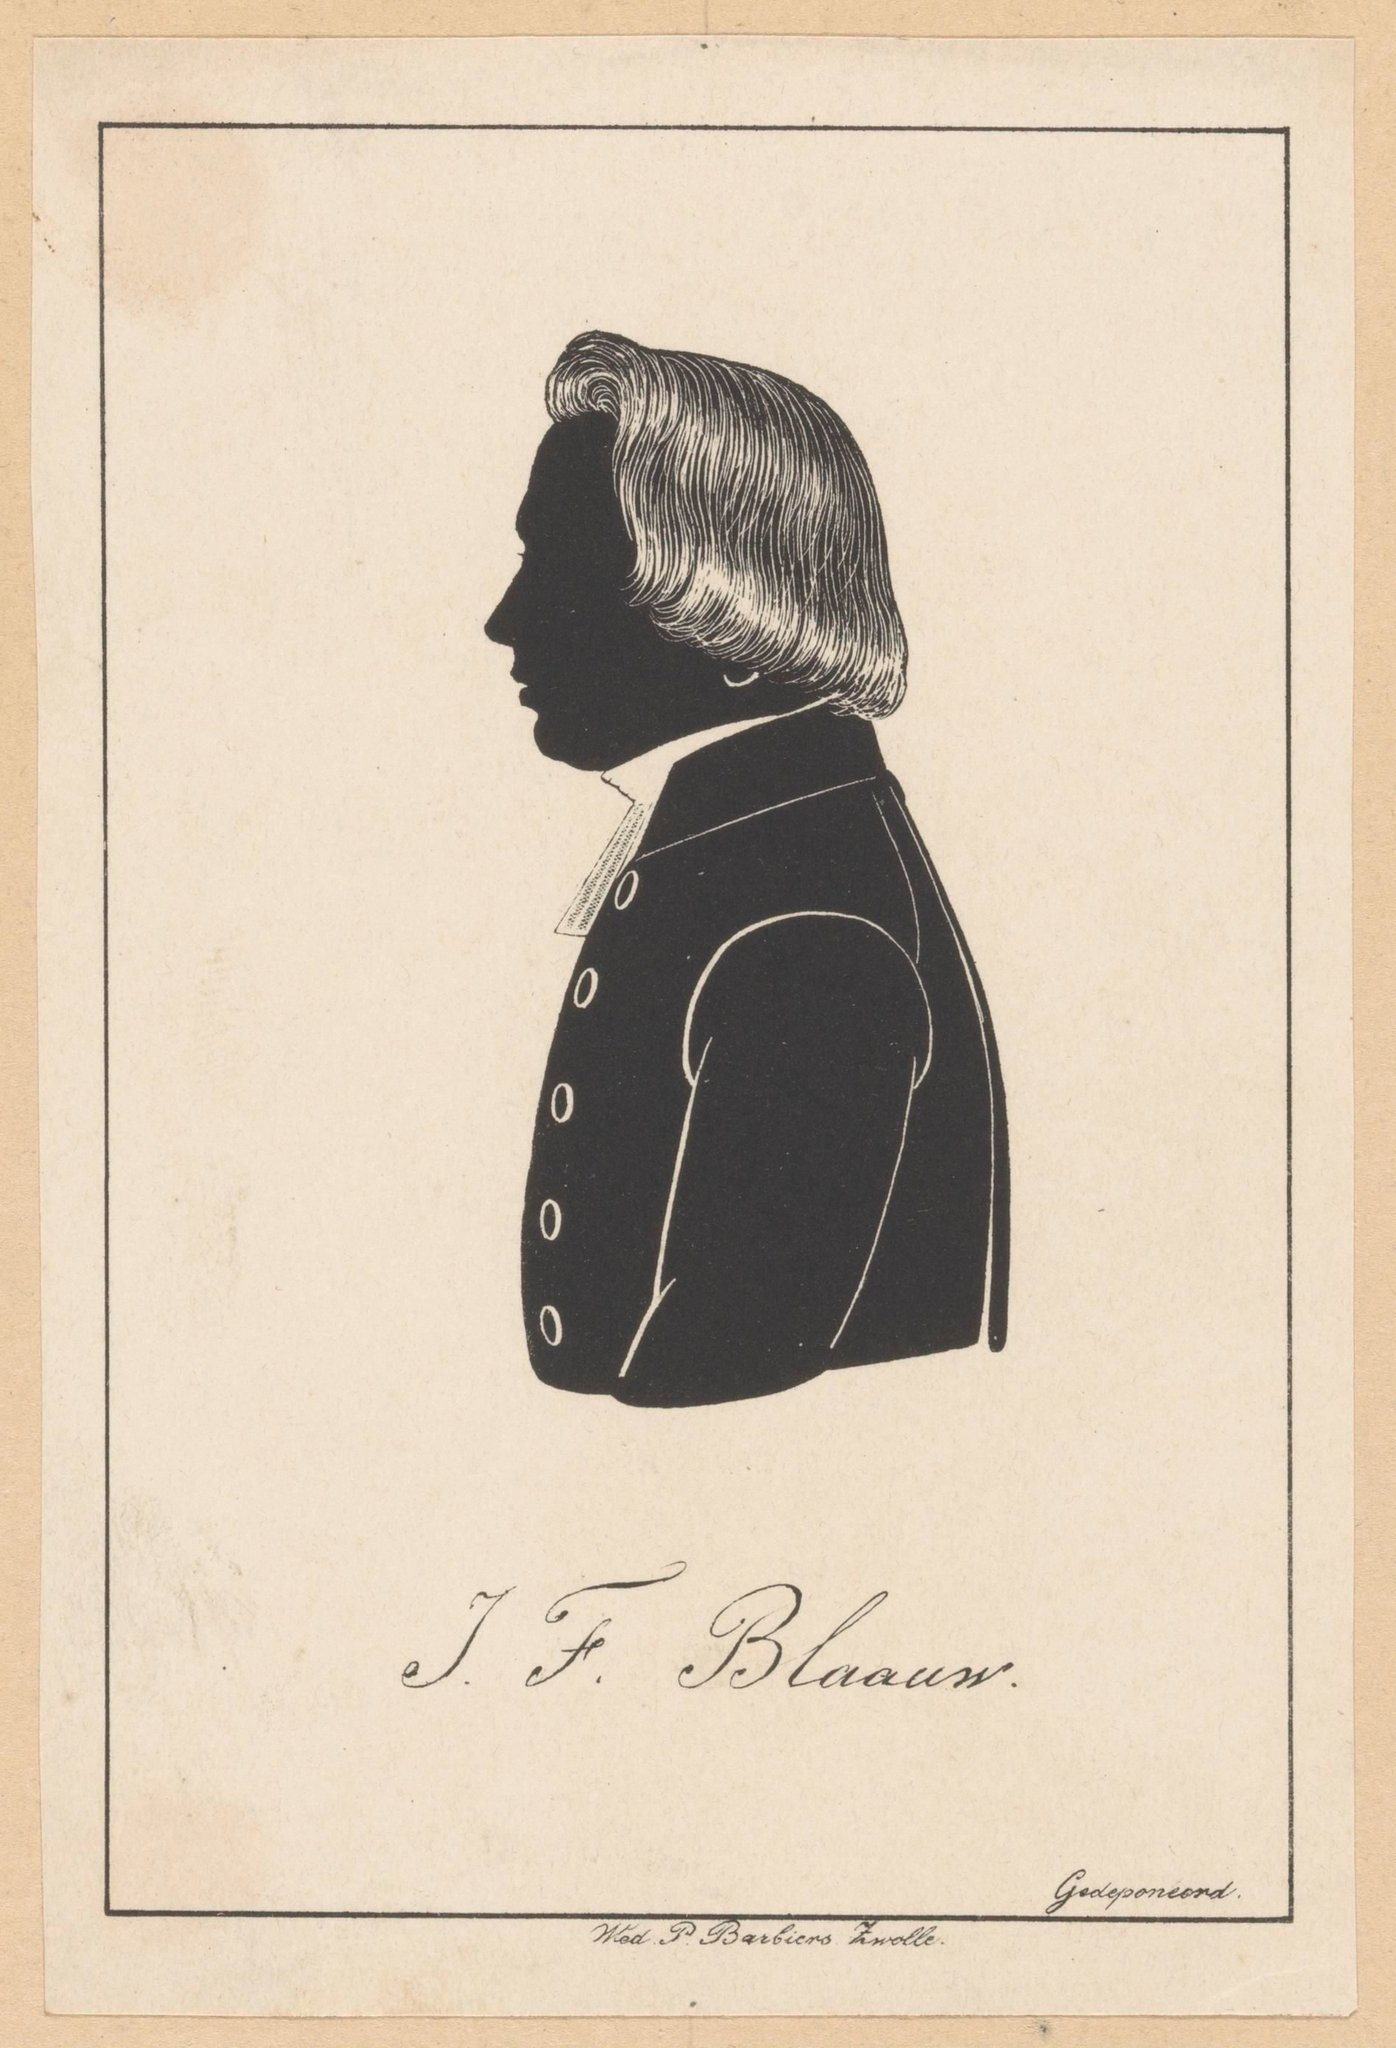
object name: print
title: Silhouetportret van Josephus Franciscus Blaauw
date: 1848-1862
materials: paper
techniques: lithograph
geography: zwolle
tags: arnhem, historical persons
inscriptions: : ‘Gedeponeerd.’, collector's mark: Lugt 2228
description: Onder het portret de signatuur van de geportretteerde.